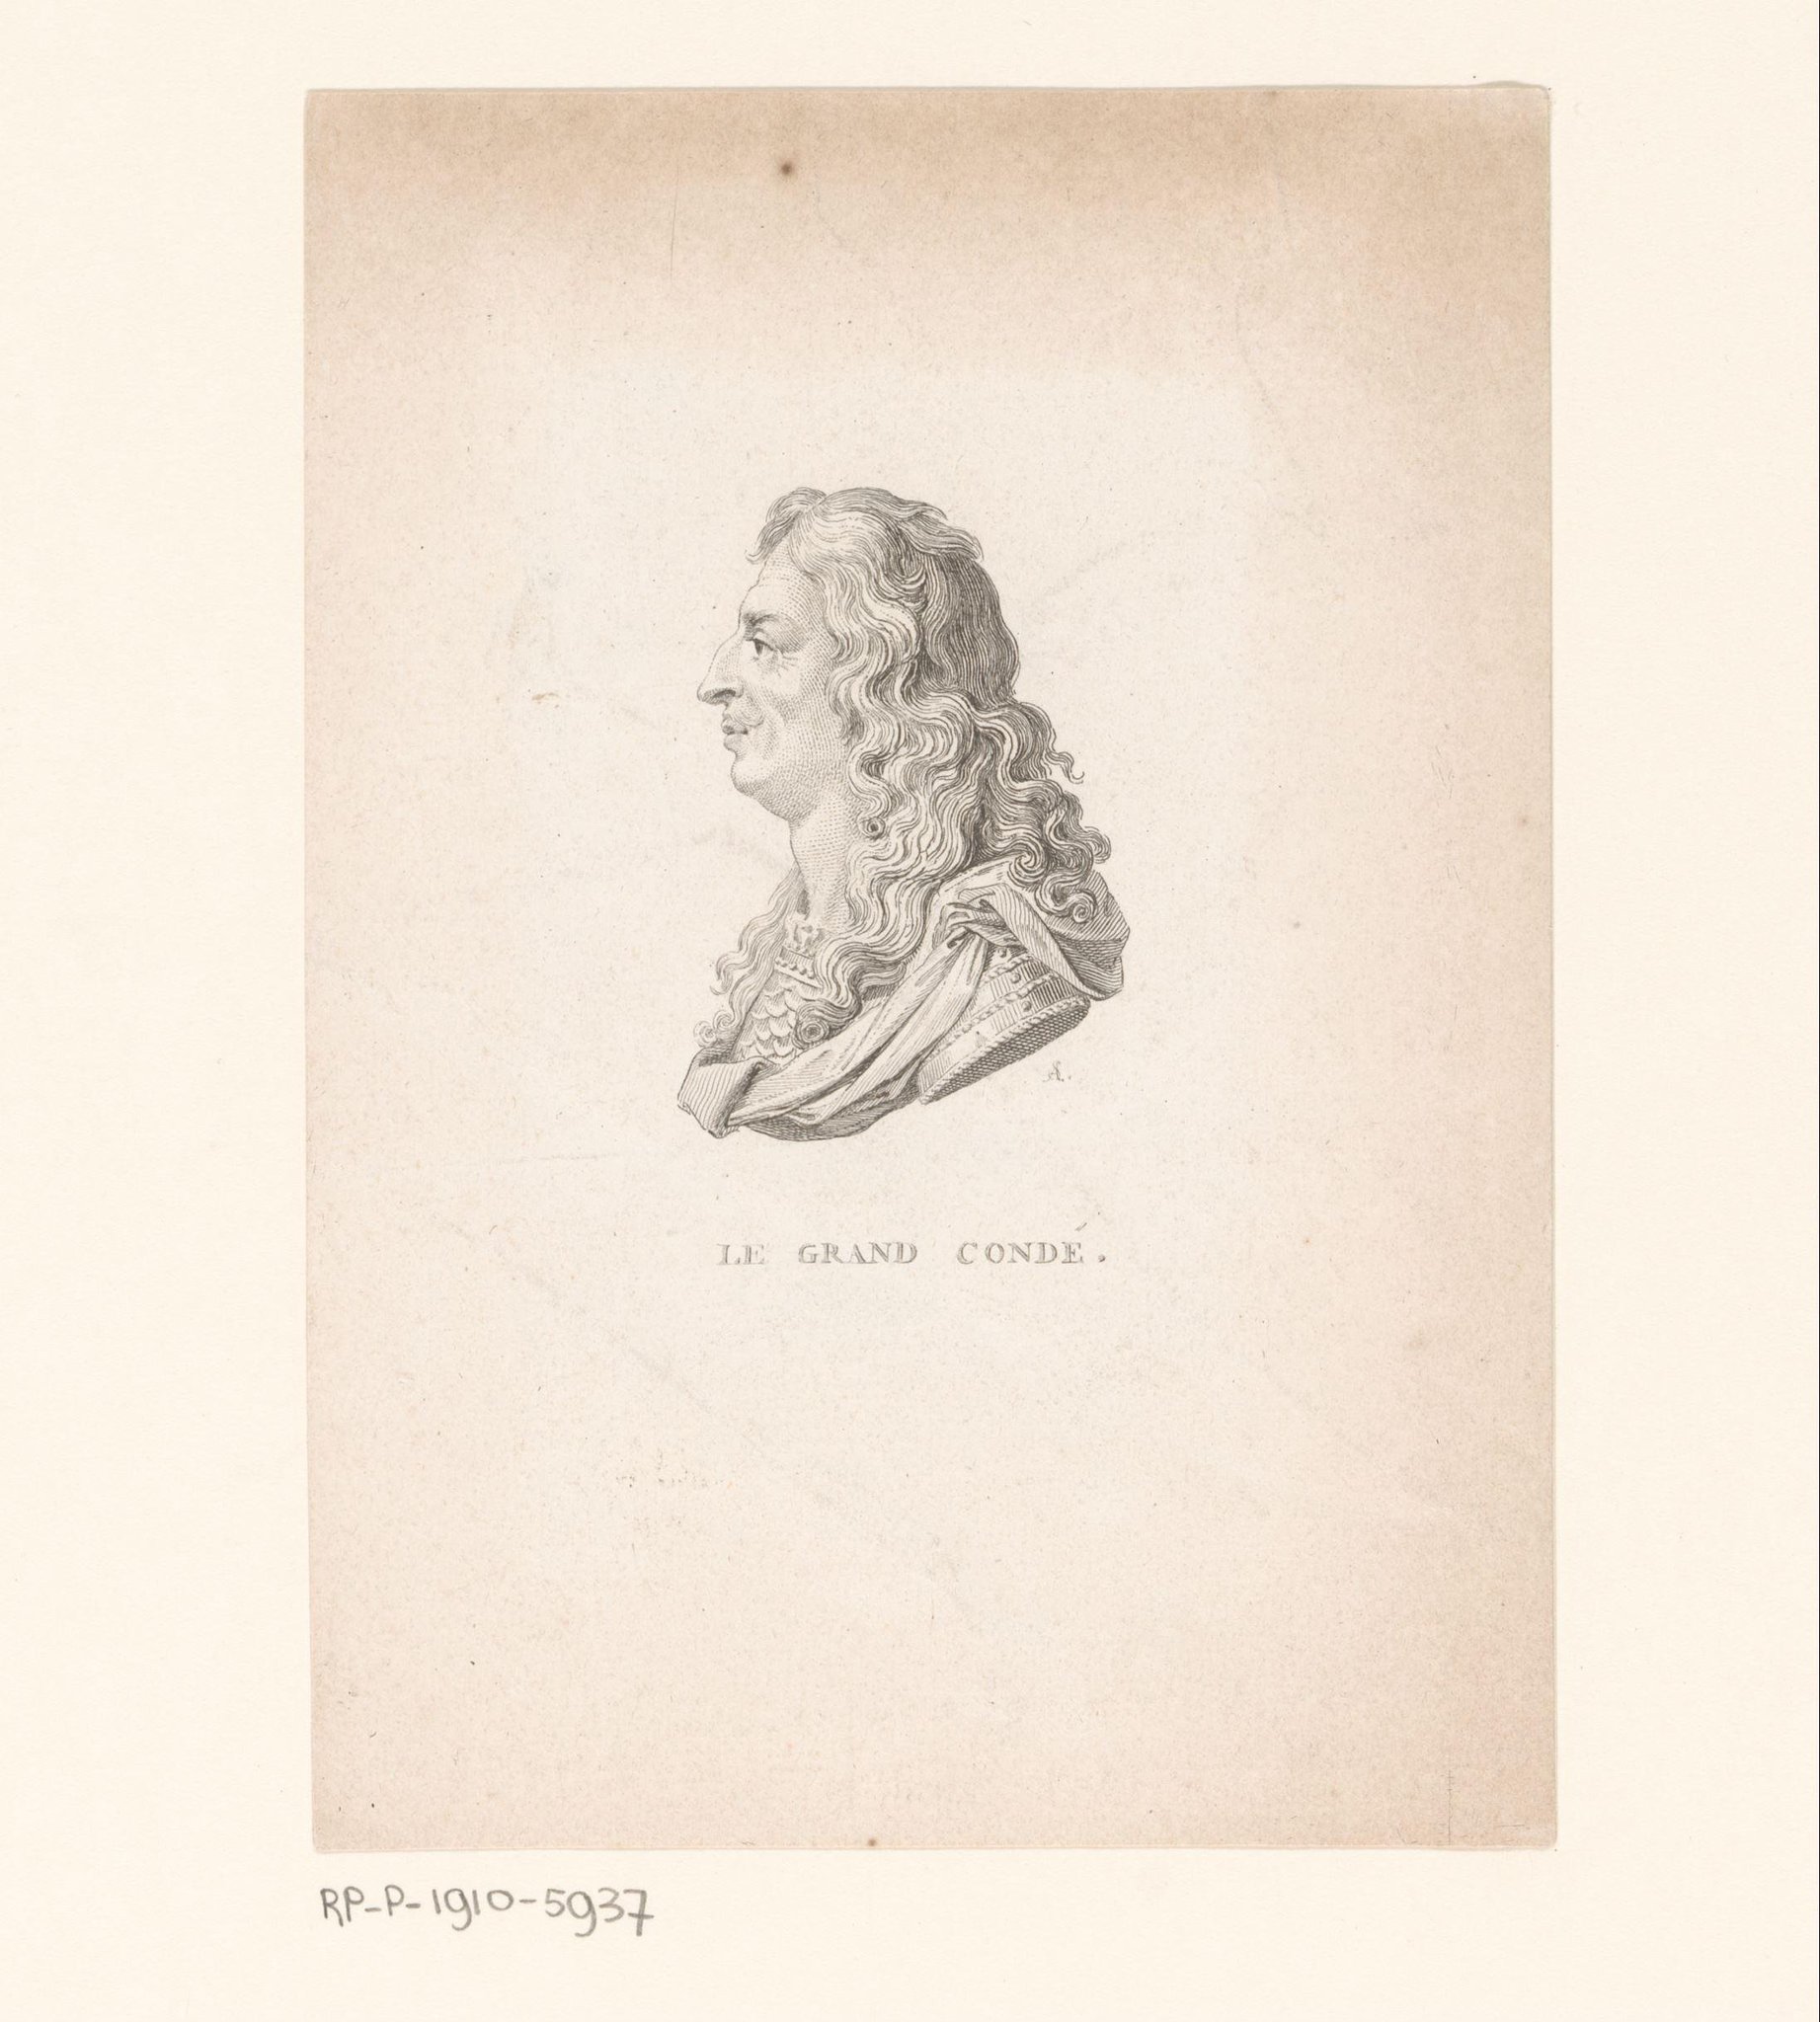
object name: print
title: Portret van Lodewijk II de Bourbon-Condé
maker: augustin de saint-aubin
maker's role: draughtsman, print maker, publisher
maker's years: 1736-1807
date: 1800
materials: paper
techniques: engraving, etching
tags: paris, lodewijk ii de bourbon-condé (hertog van enghien), ranks in the army, historical persons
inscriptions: collector's mark: Lugt 2228